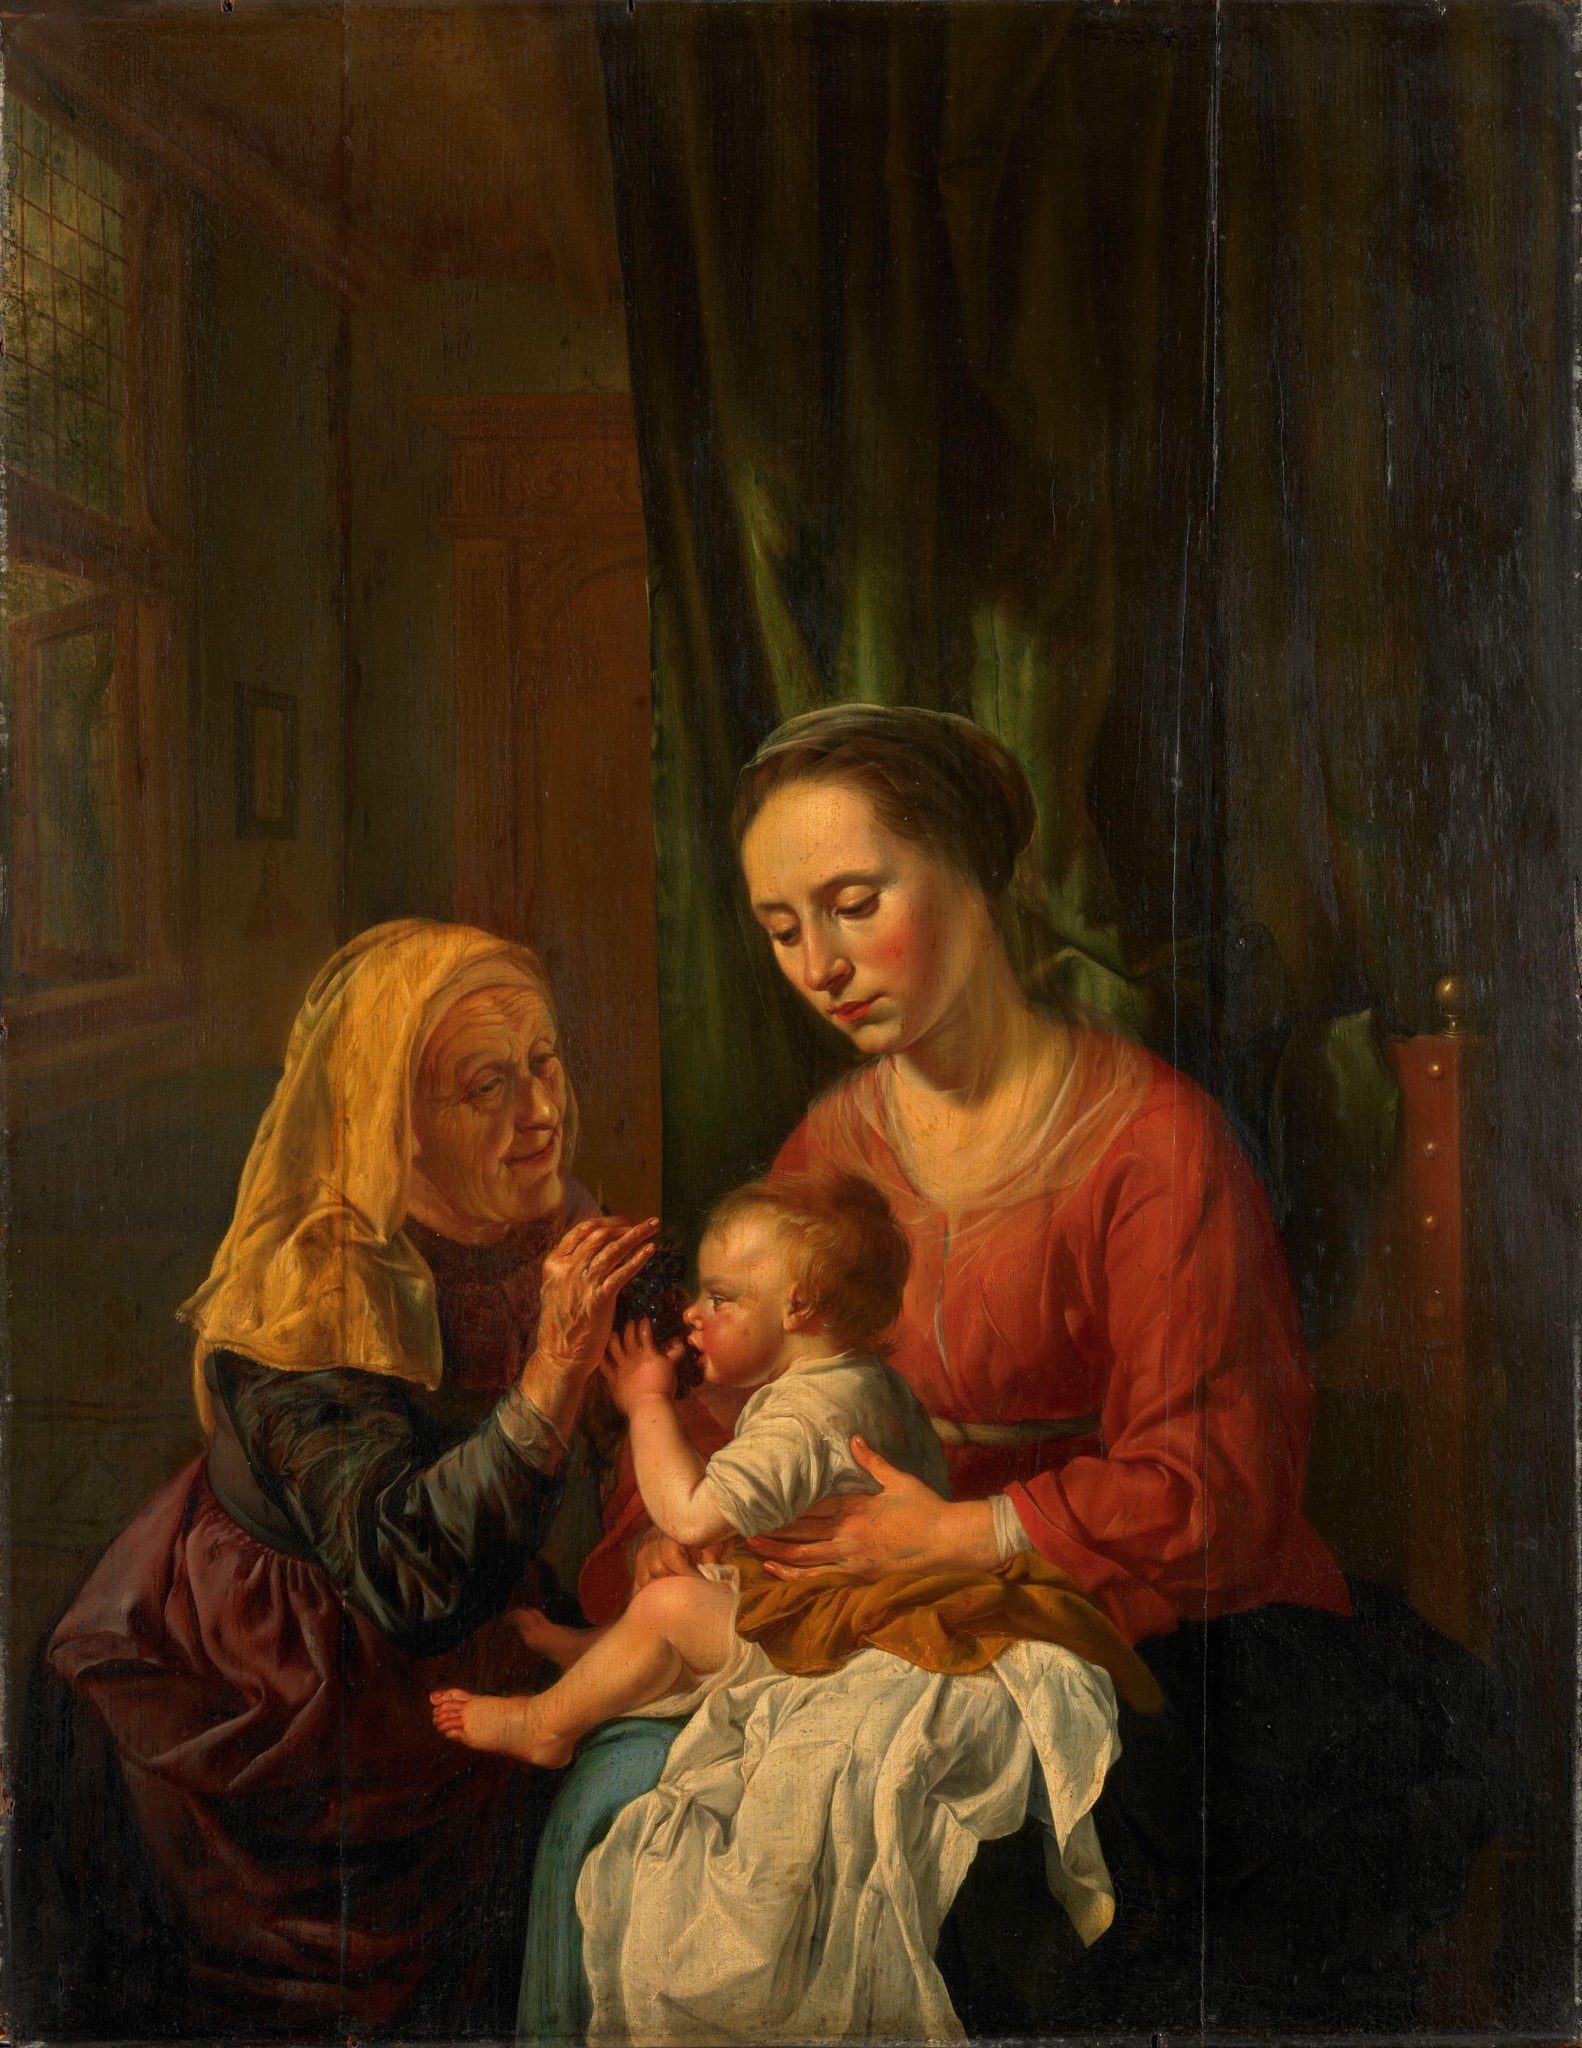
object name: painting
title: Virgin and Child with St Anne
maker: dirk van hoogstraten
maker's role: painter, print maker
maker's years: 1596-1640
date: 1630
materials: oil, panel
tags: 'anna selbdritt', i.e. anna, mary and christ-child close together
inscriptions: signature and date, on the chair: ‘D V / hoochstraten. ƒecit 1630’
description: Interieur met Maria met het Christuskind op schoot. Links de heilige Anna die het kind een tros druiven te eten geeft.